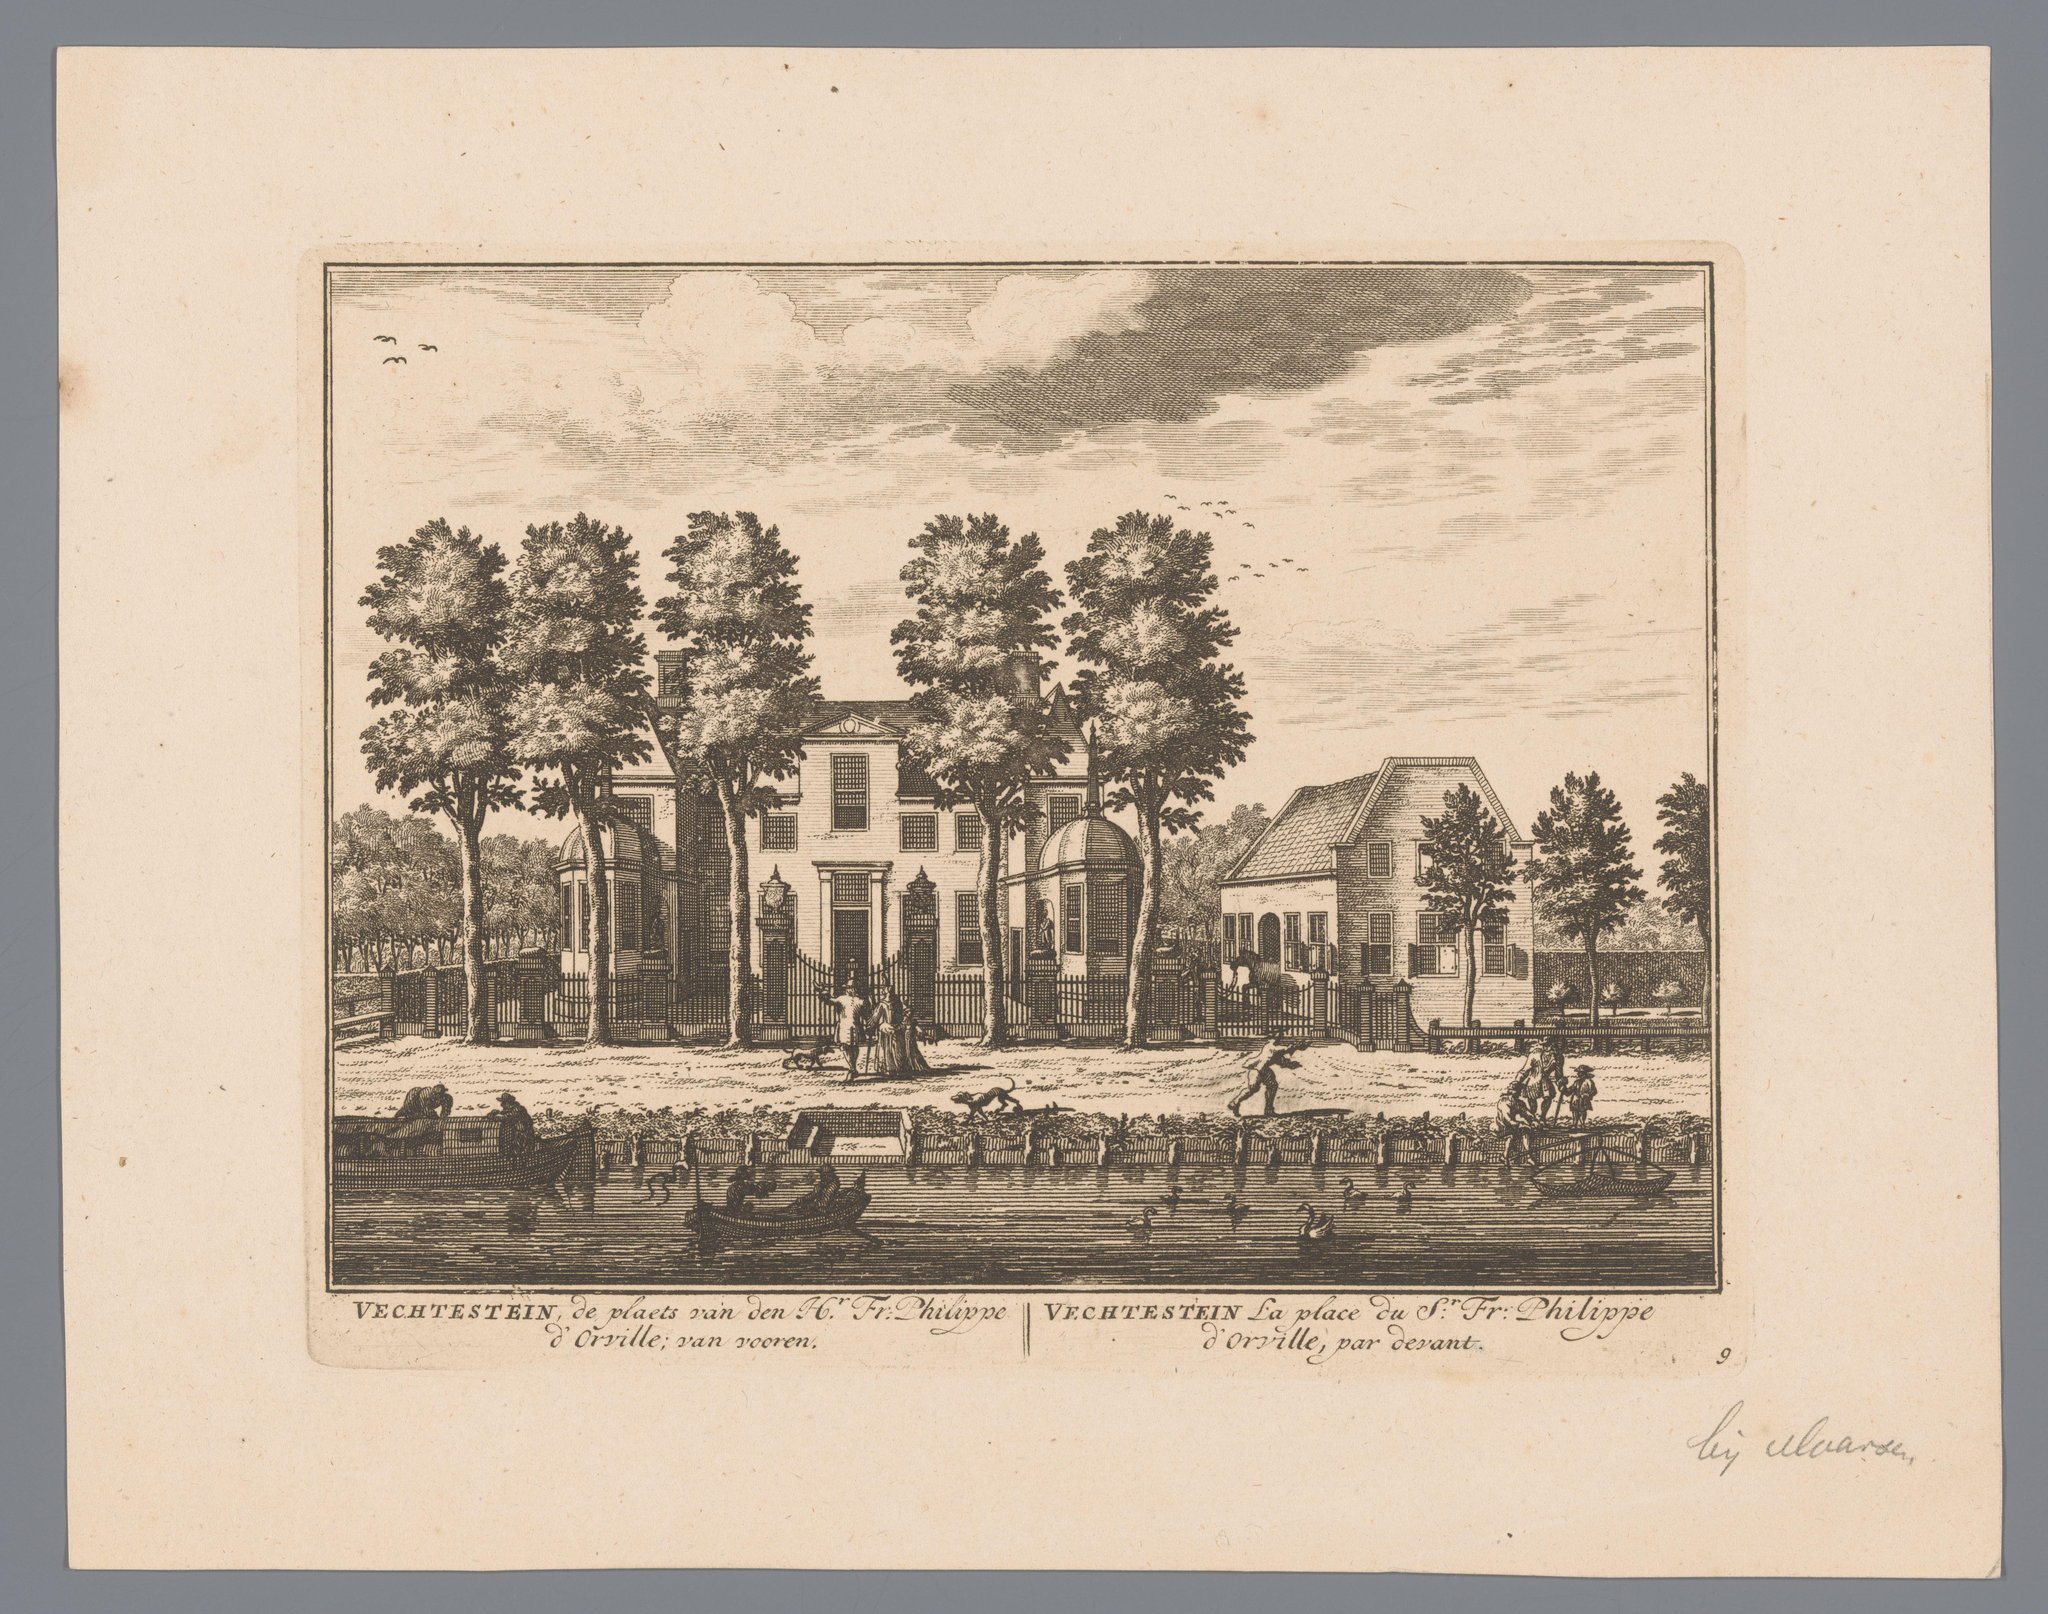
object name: print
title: Vechtestein, de plaets van den Hr. Fr: Philippe d'Orville; van vooren / Vechtestein La place de Sr. Fr: Philippe d'Orville, par devant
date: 1719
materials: paper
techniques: etching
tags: river, rural housing, e.g. country-house, villa, cottage, vecht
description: Prent uit: De zegepraalende Vecht, vertoonende verscheidene gesichten van lustplaatsen, heeren huysen en dorpen, beginnende van Uitrecht en met Muyden besluytende. Amsterdam: Wed. Nicolaes Visscher, 1719.